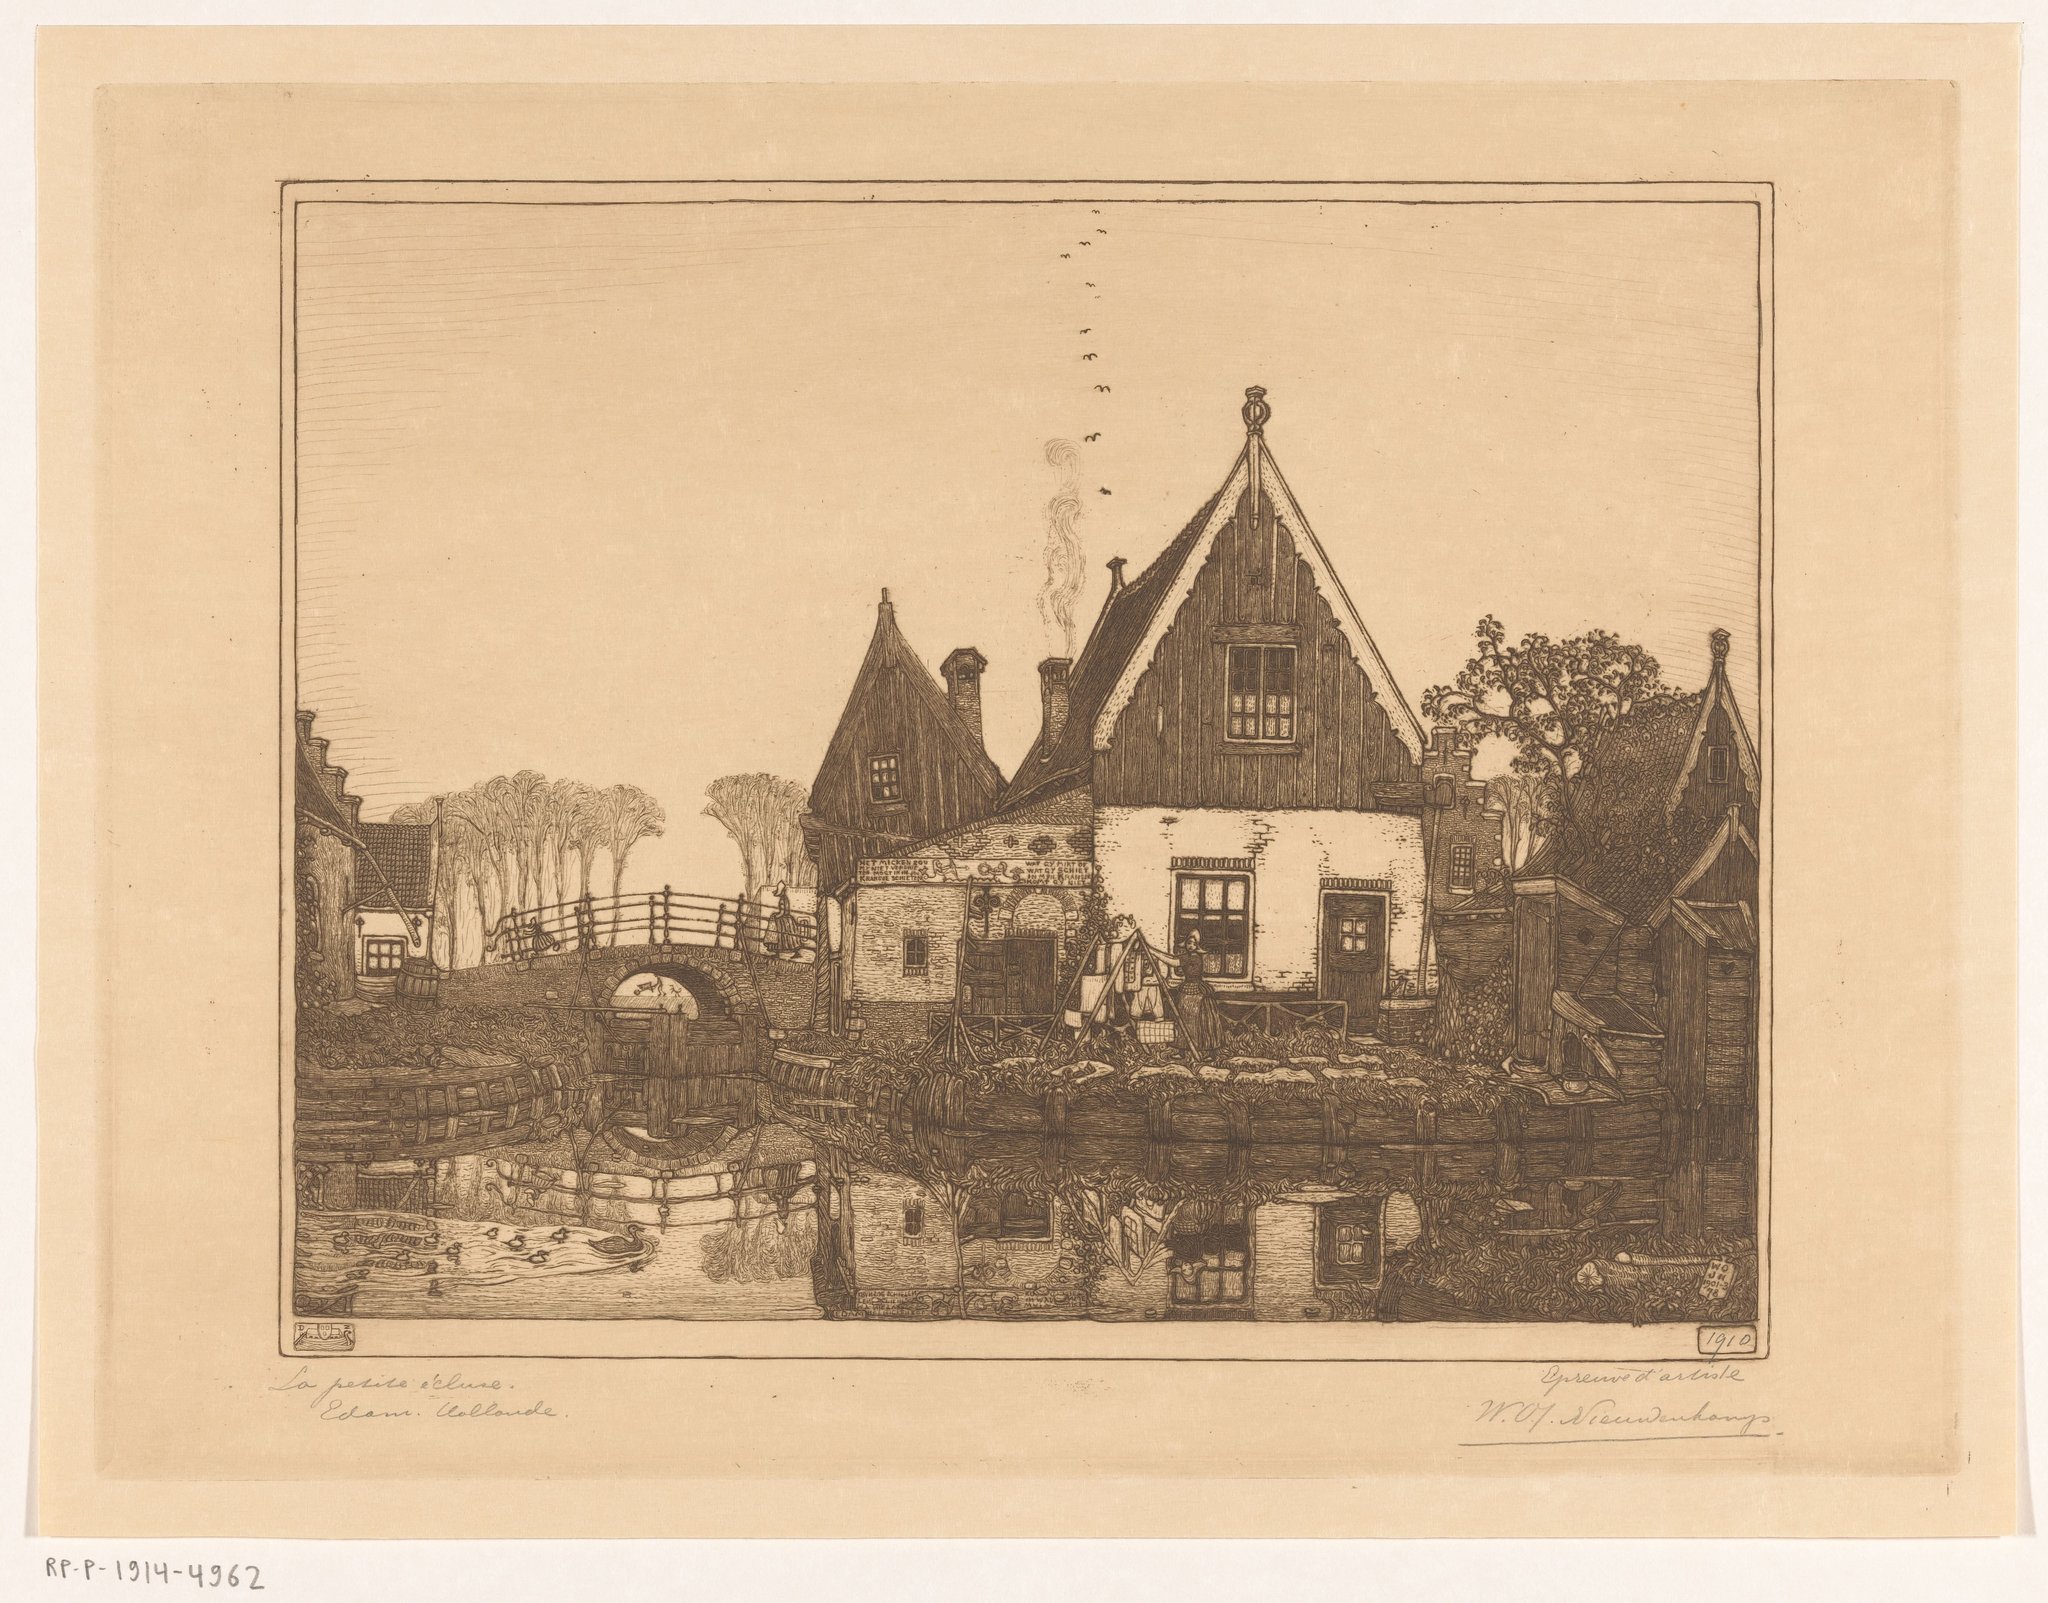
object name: print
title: Diendersluis in Edam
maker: wijnand otto jan nieuwenkamp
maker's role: draughtsman, print maker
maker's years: 1874-1950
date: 1903-1908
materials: paper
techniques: etching, intaglio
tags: sluice, weir, folk costume, regional costume, water-birds: duck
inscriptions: collector's mark: Lugt 2233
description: Op de sluis een vrouw en een meisje in klederdracht. Aan weerszijden van de sluis huizen. Op de voorgrond een eend met jongen in het water.